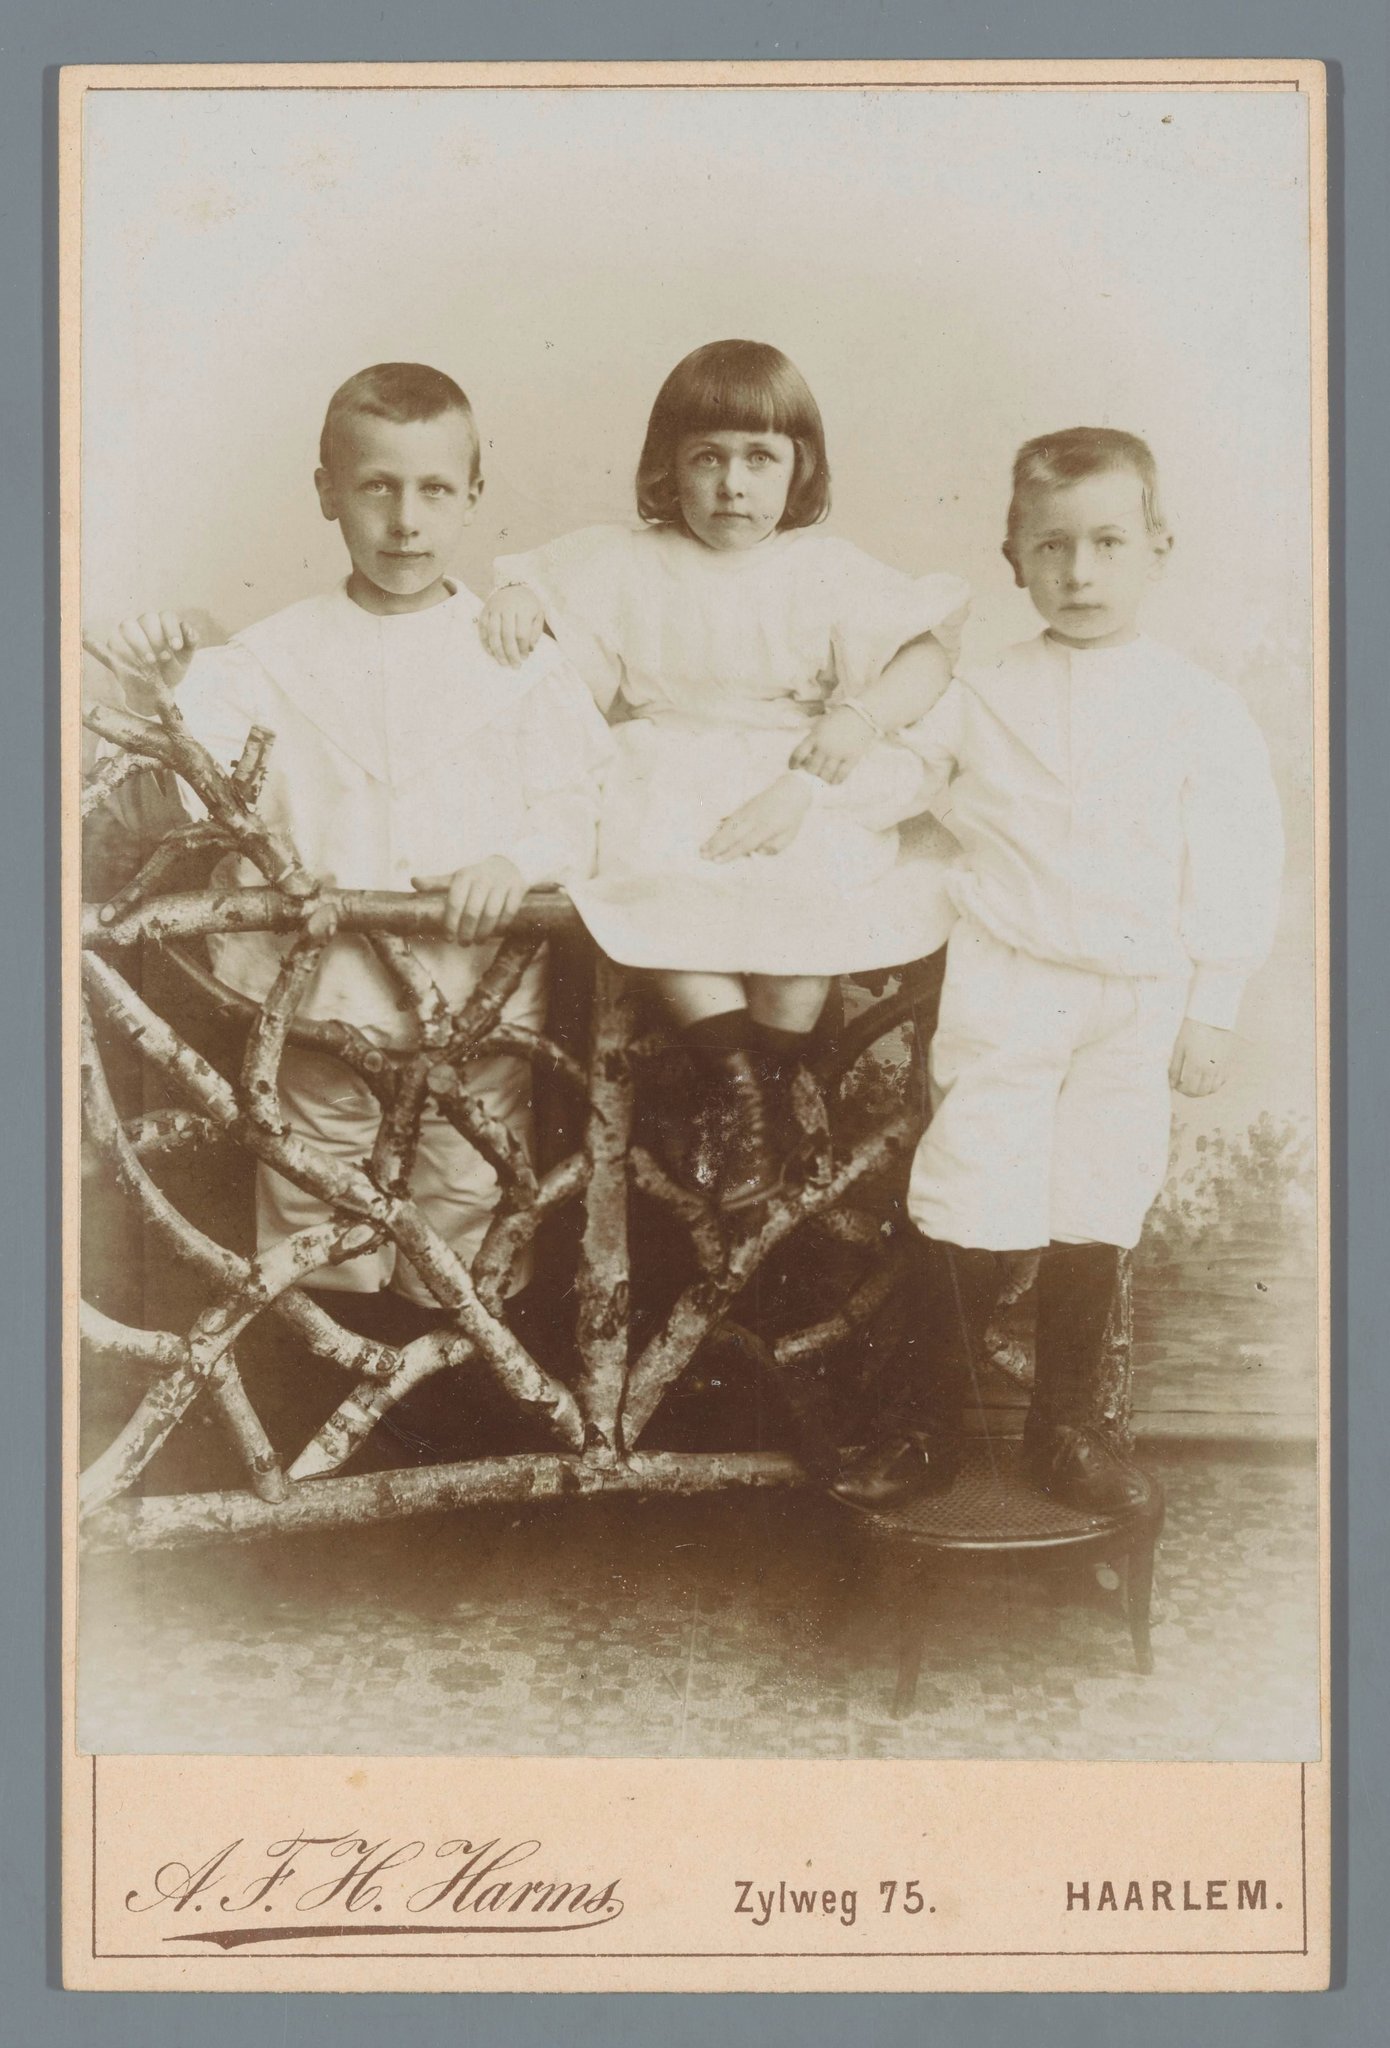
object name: cabinet photograph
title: Portret van drie kinderen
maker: august ferdinand heinrich harms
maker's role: fotograaf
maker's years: 1845-1916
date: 1884-1900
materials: cardboard, photographic support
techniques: collodion silver print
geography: haarlem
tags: studio requisites ~ photographer, child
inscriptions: name: ‘A.F.H. Harms Haarlem Zylweg 75’